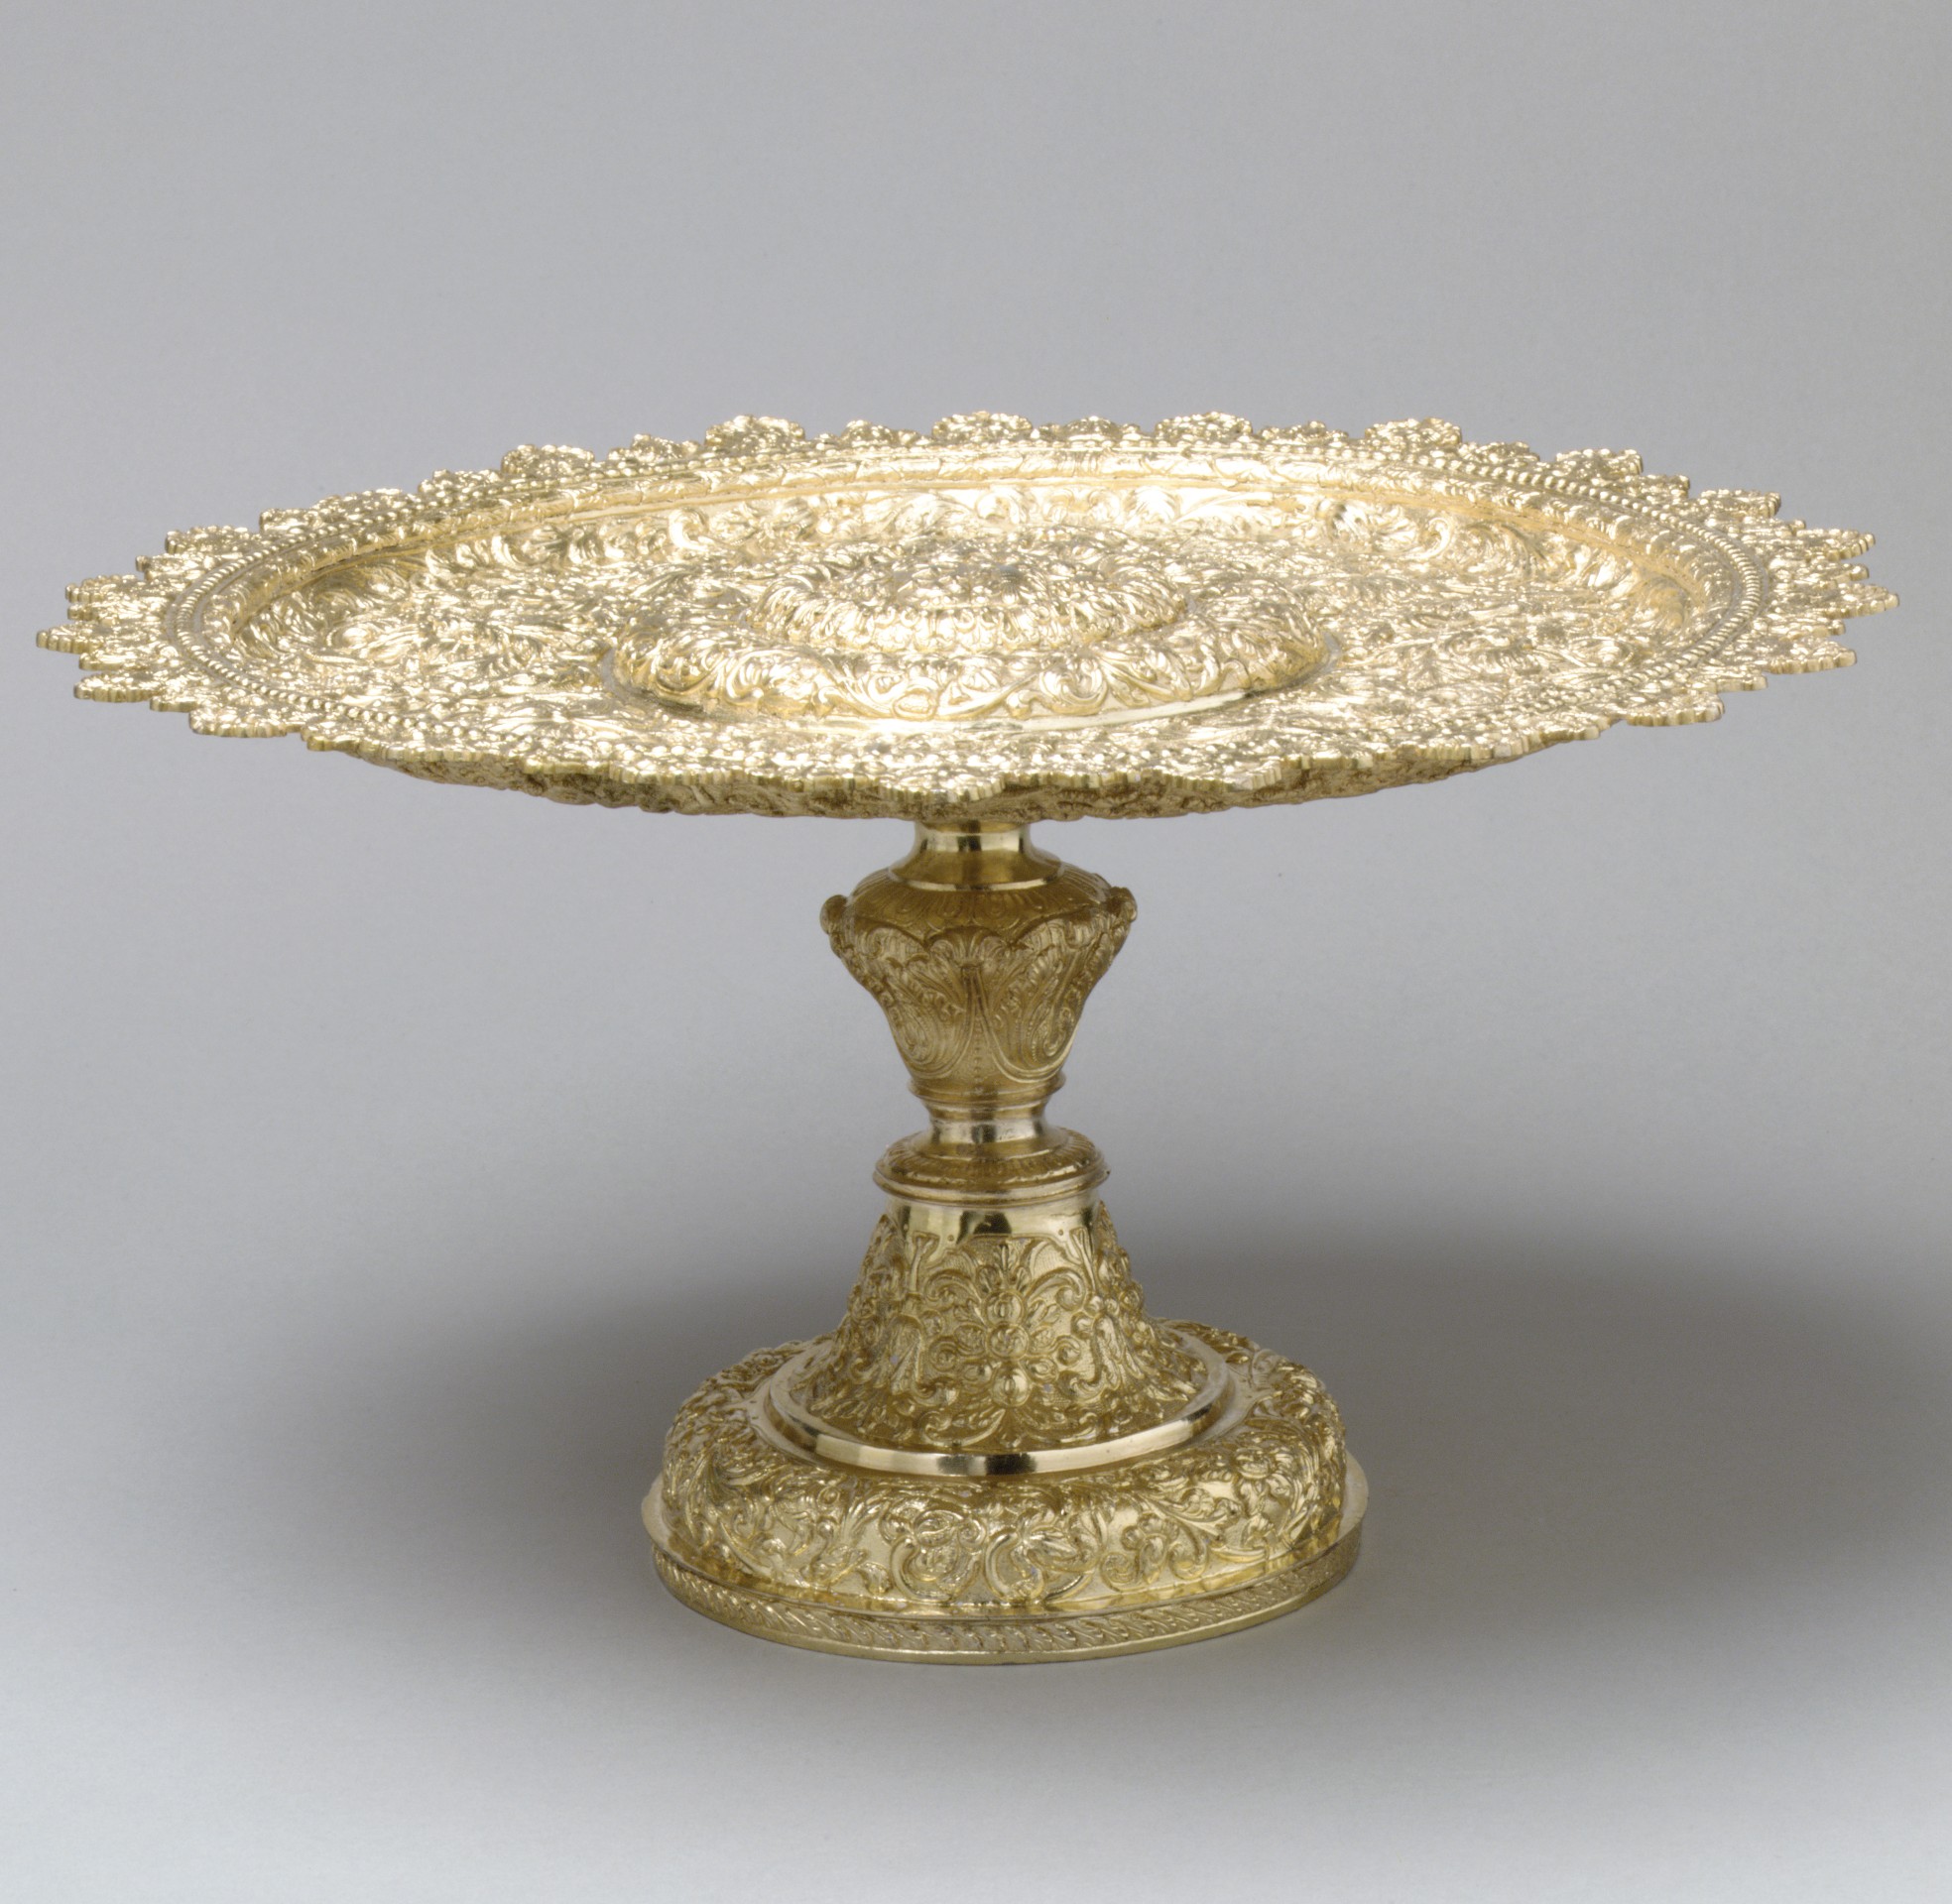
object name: tazza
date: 1801-1900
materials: metal, silver